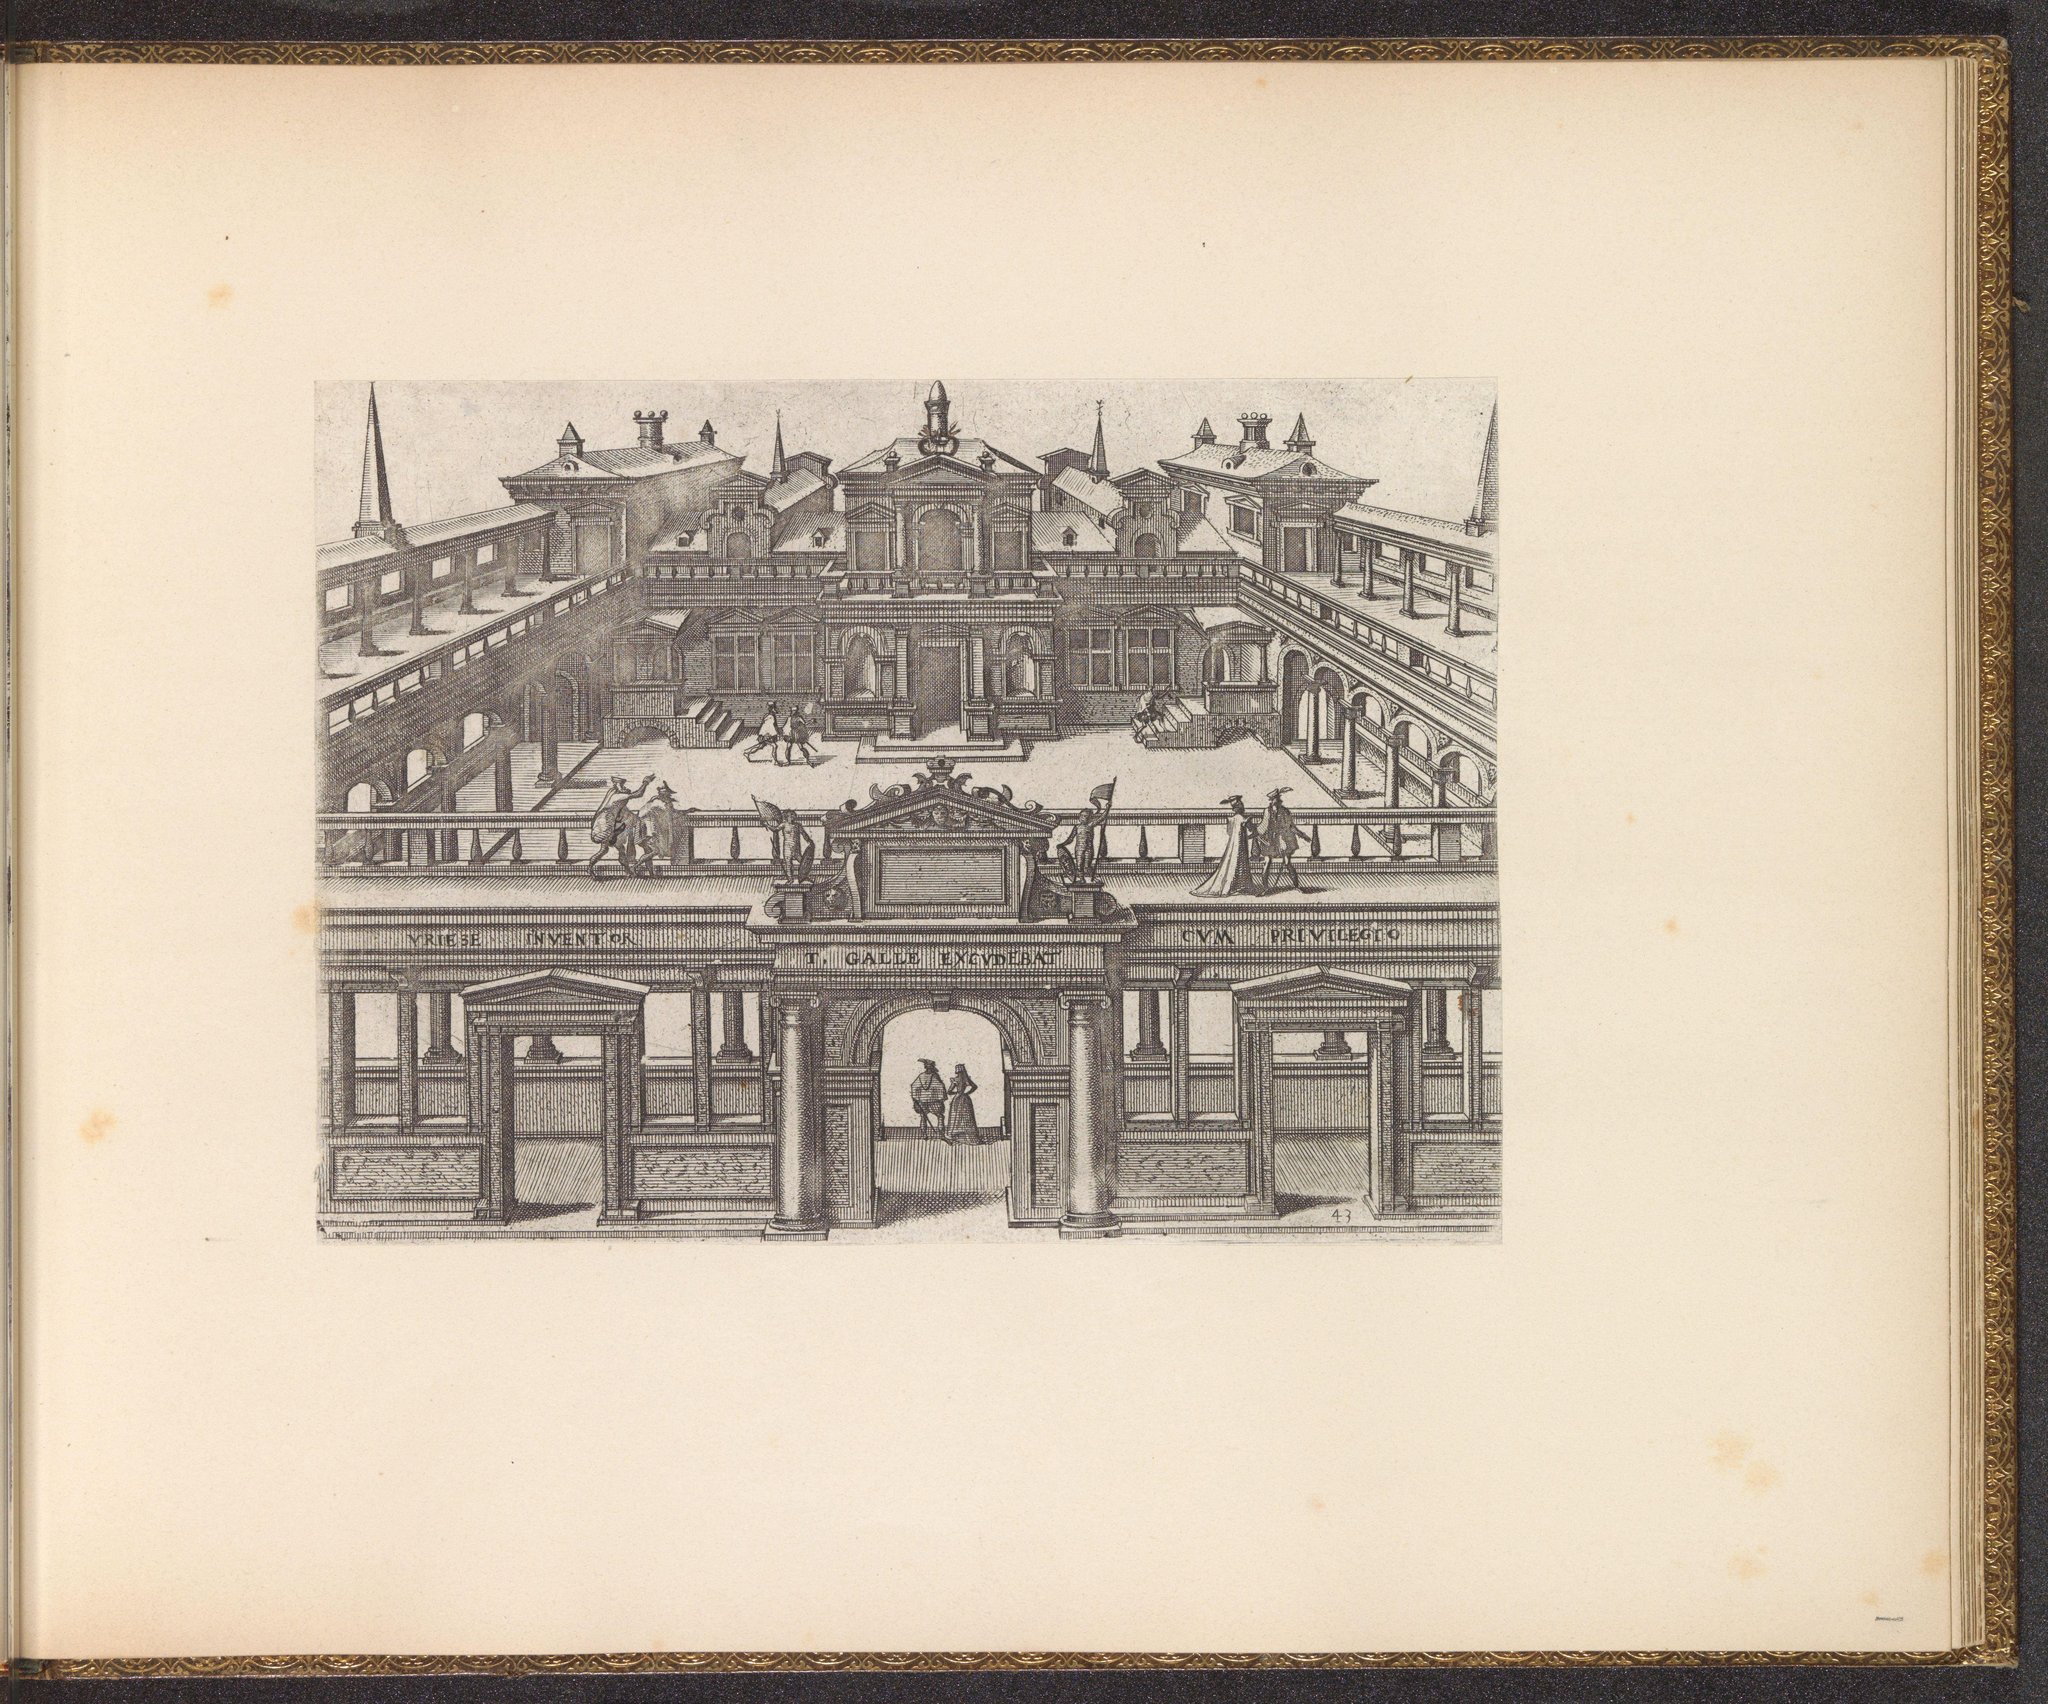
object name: print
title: Paleis met een voorplein in semi-vogelvlucht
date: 1601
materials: paper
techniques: etching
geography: antwerp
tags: colonnade, palace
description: Paleis met een voorplein waar een galerij omheen loopt in semi-vogelvlucht. In het midden bevindt zich een grote toegangspoort. Op de galerij wandelen mensen. De prent maakt deel uit van een album.